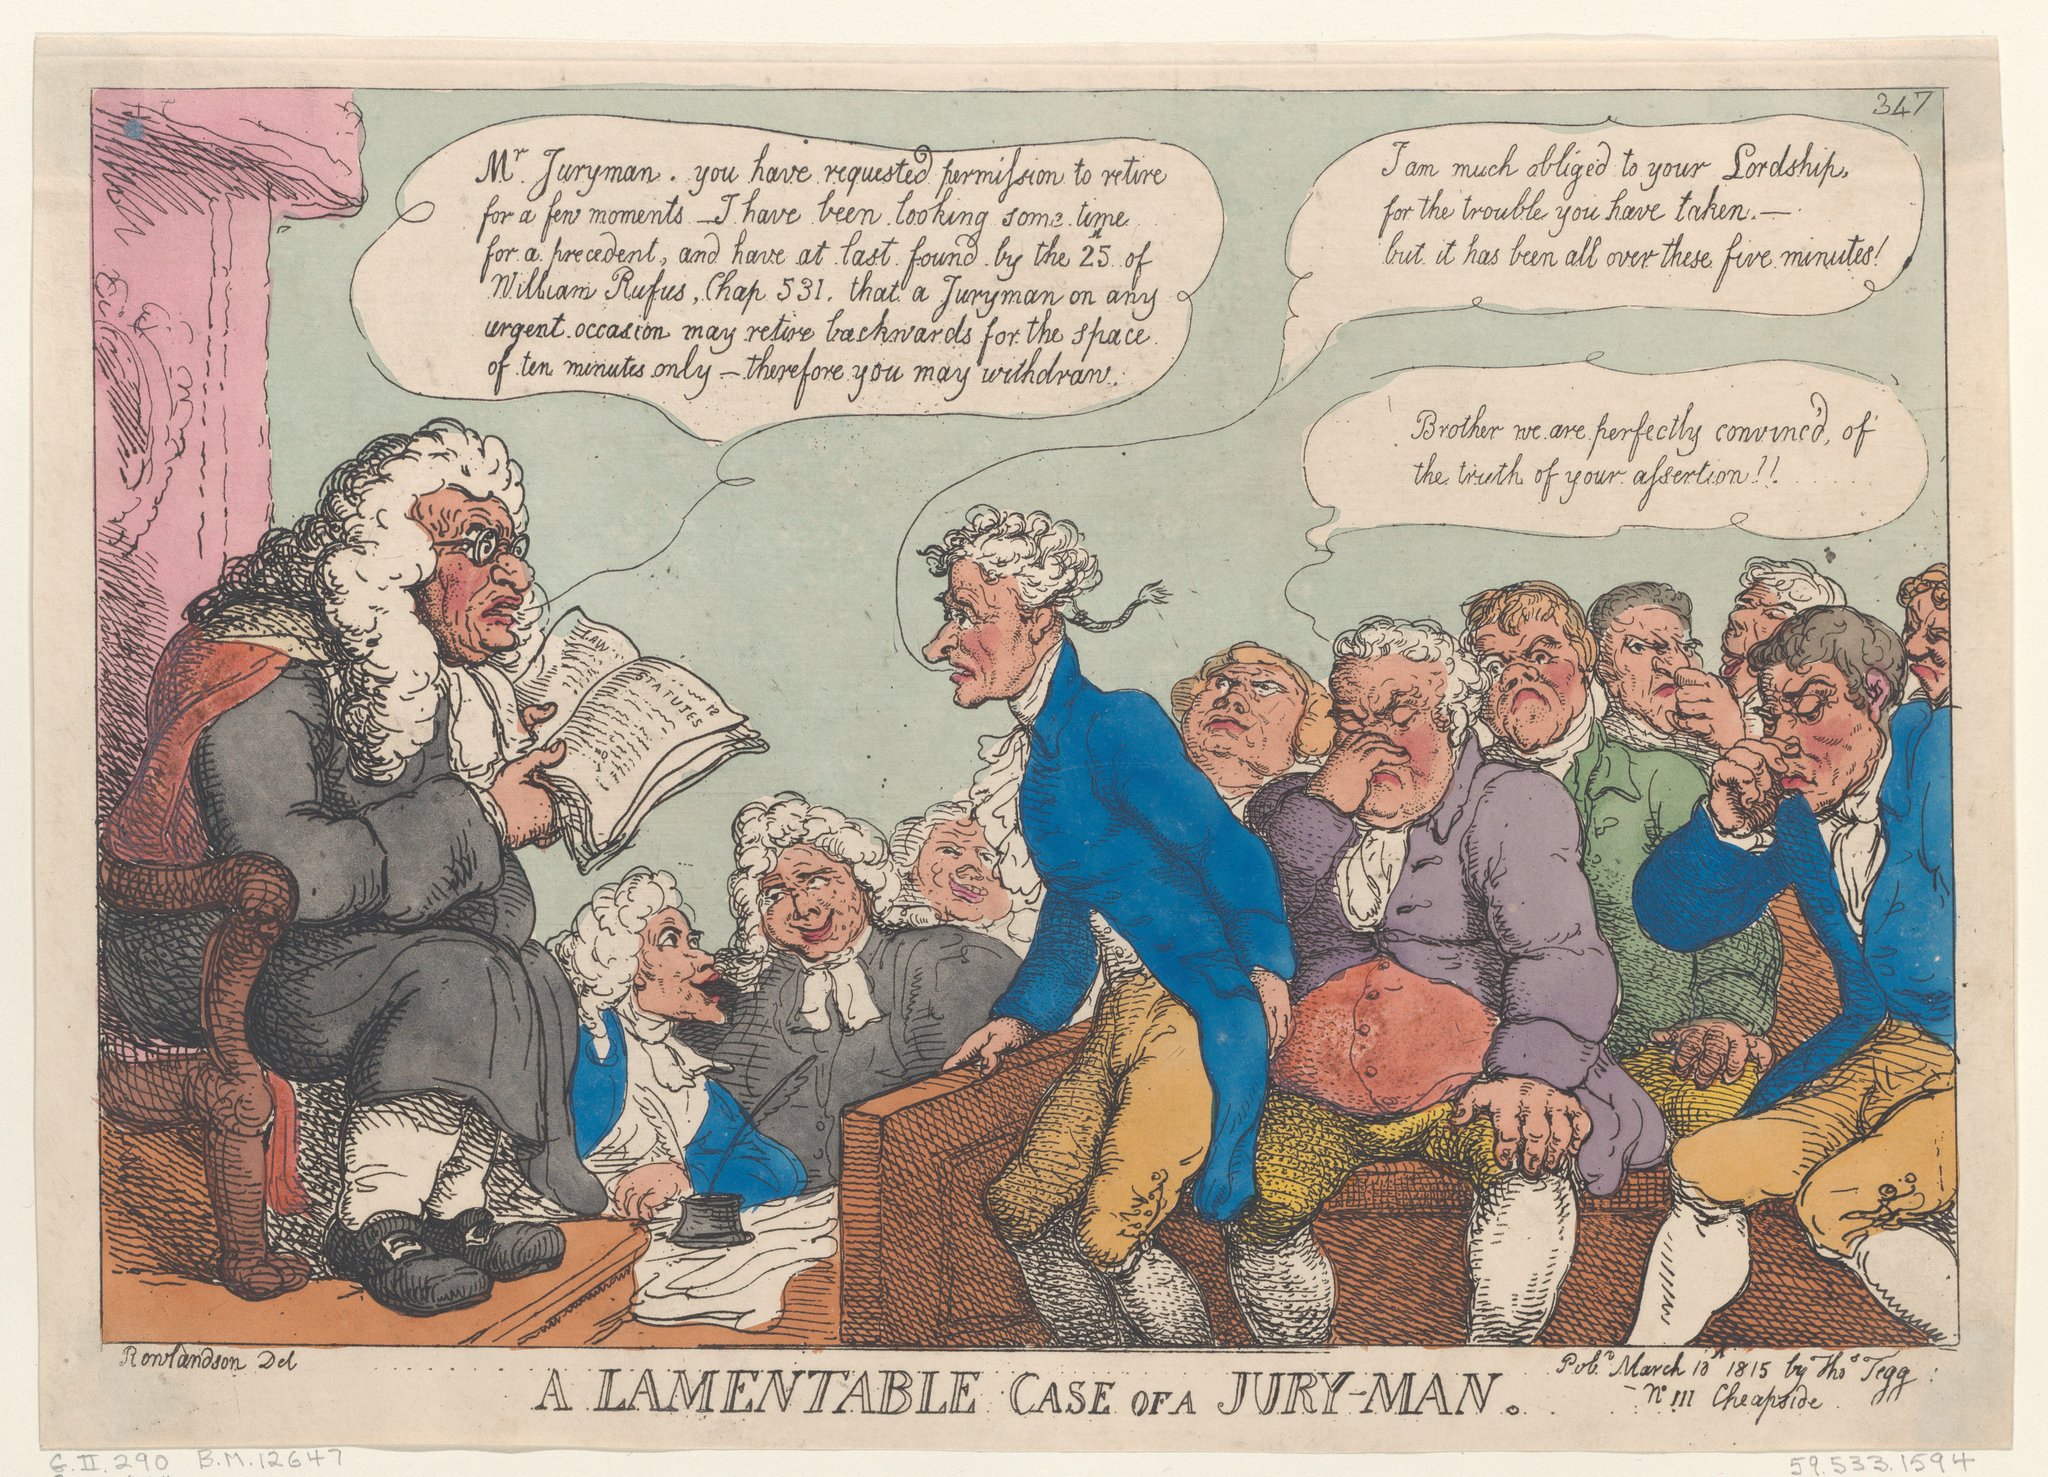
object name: print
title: A Lamentable Case of a Jury-Man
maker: thomas rowlandson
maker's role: artist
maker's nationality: british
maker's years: 1757-1827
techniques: etching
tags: satire,men